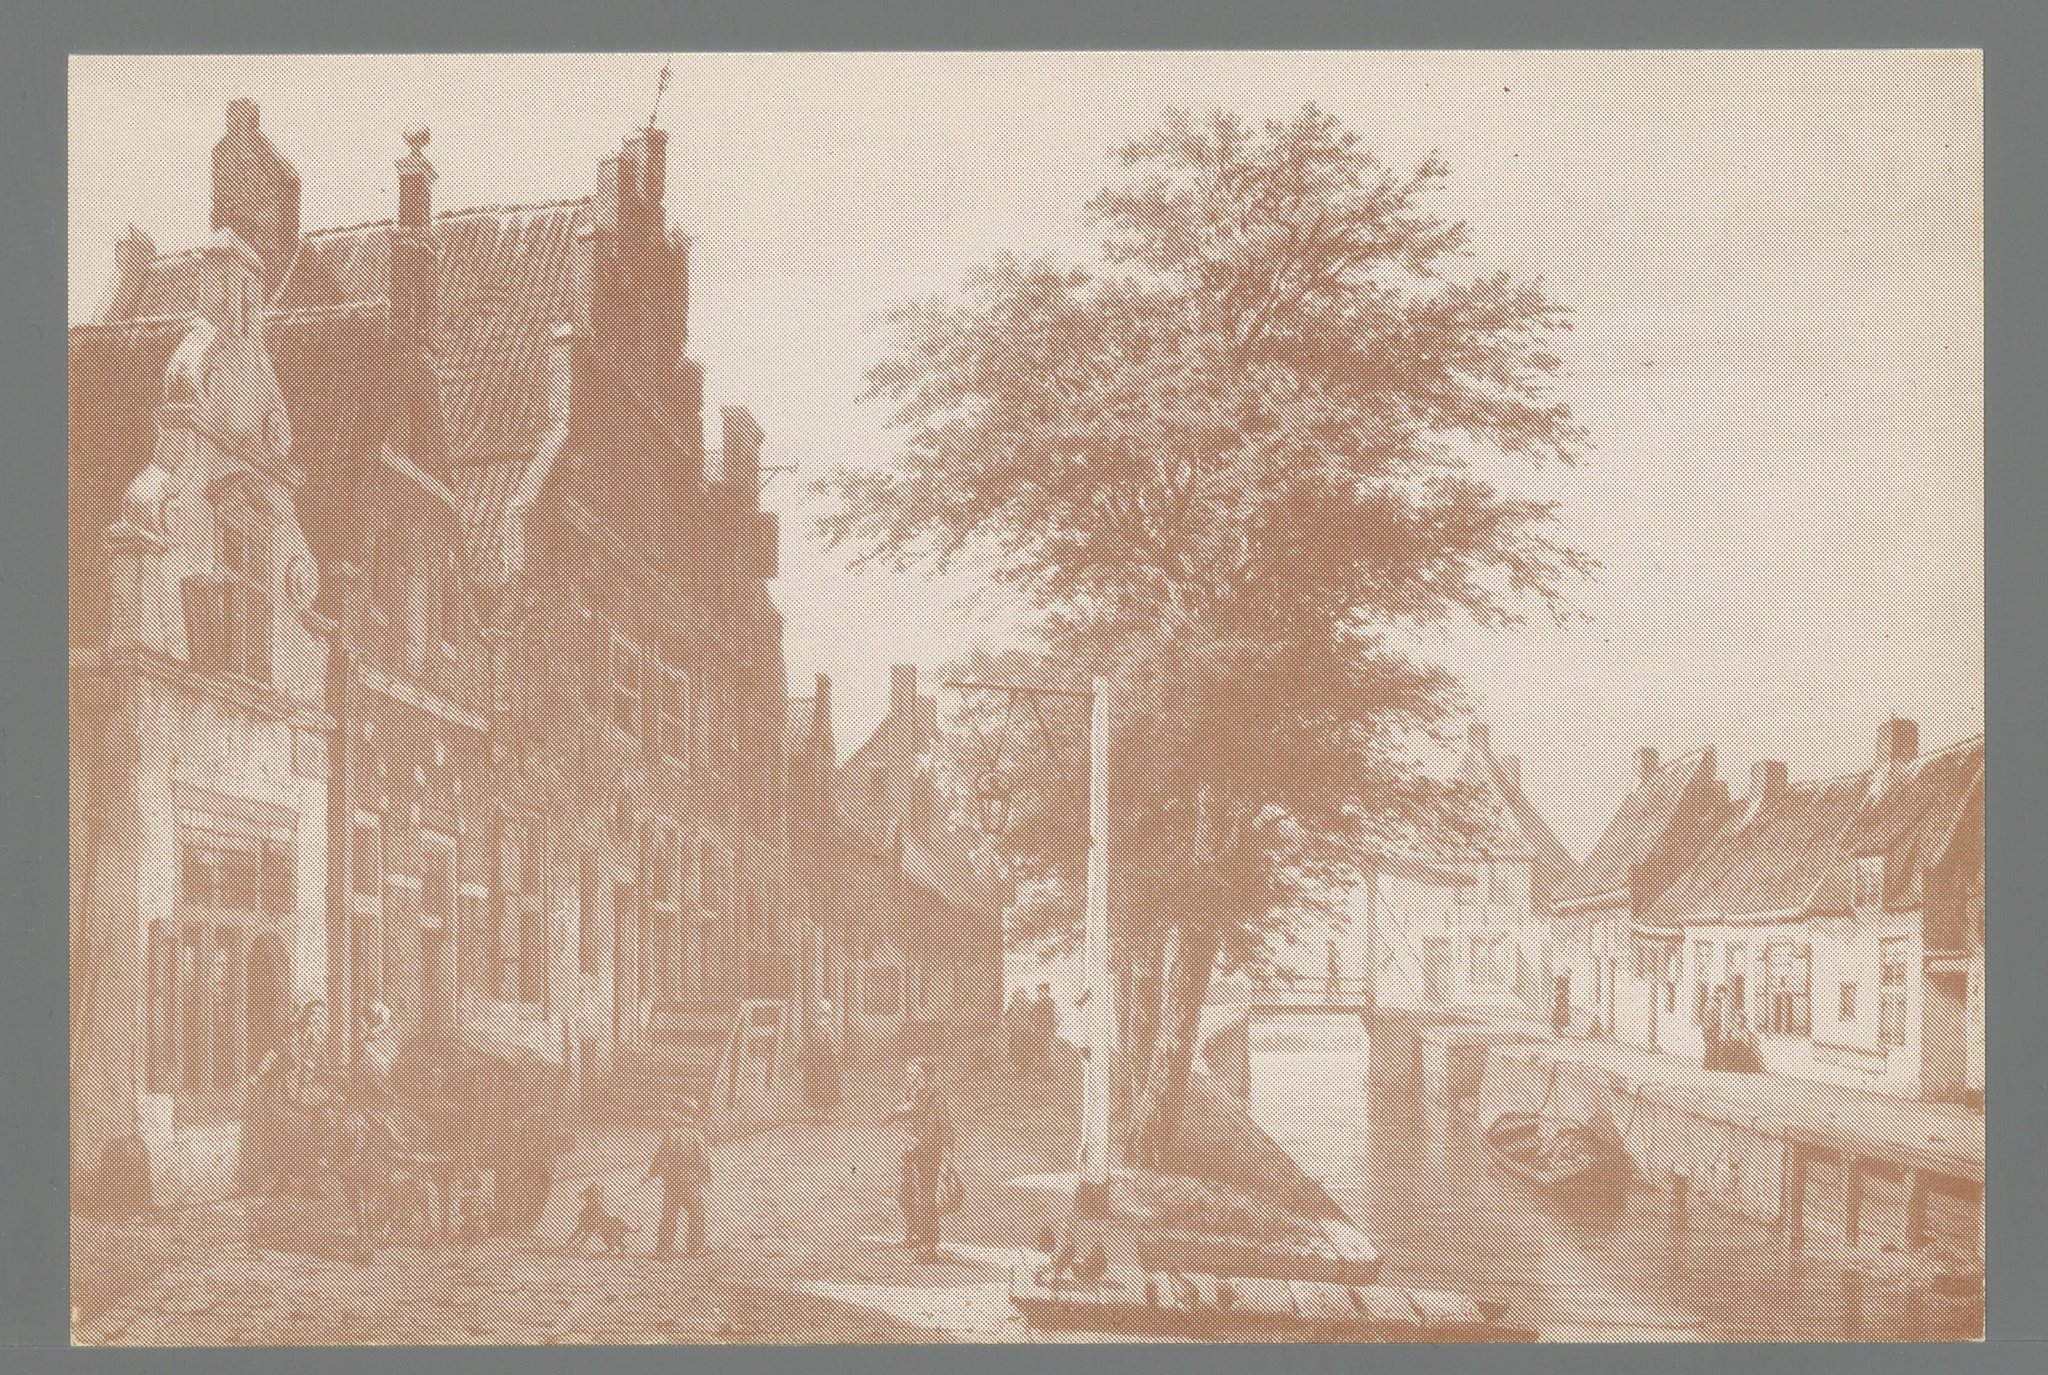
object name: reproduction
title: De Haven 19e eeuw (Hasselt)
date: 1958-2021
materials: cardboard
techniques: autotype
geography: hasselt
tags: canal, bridge, street